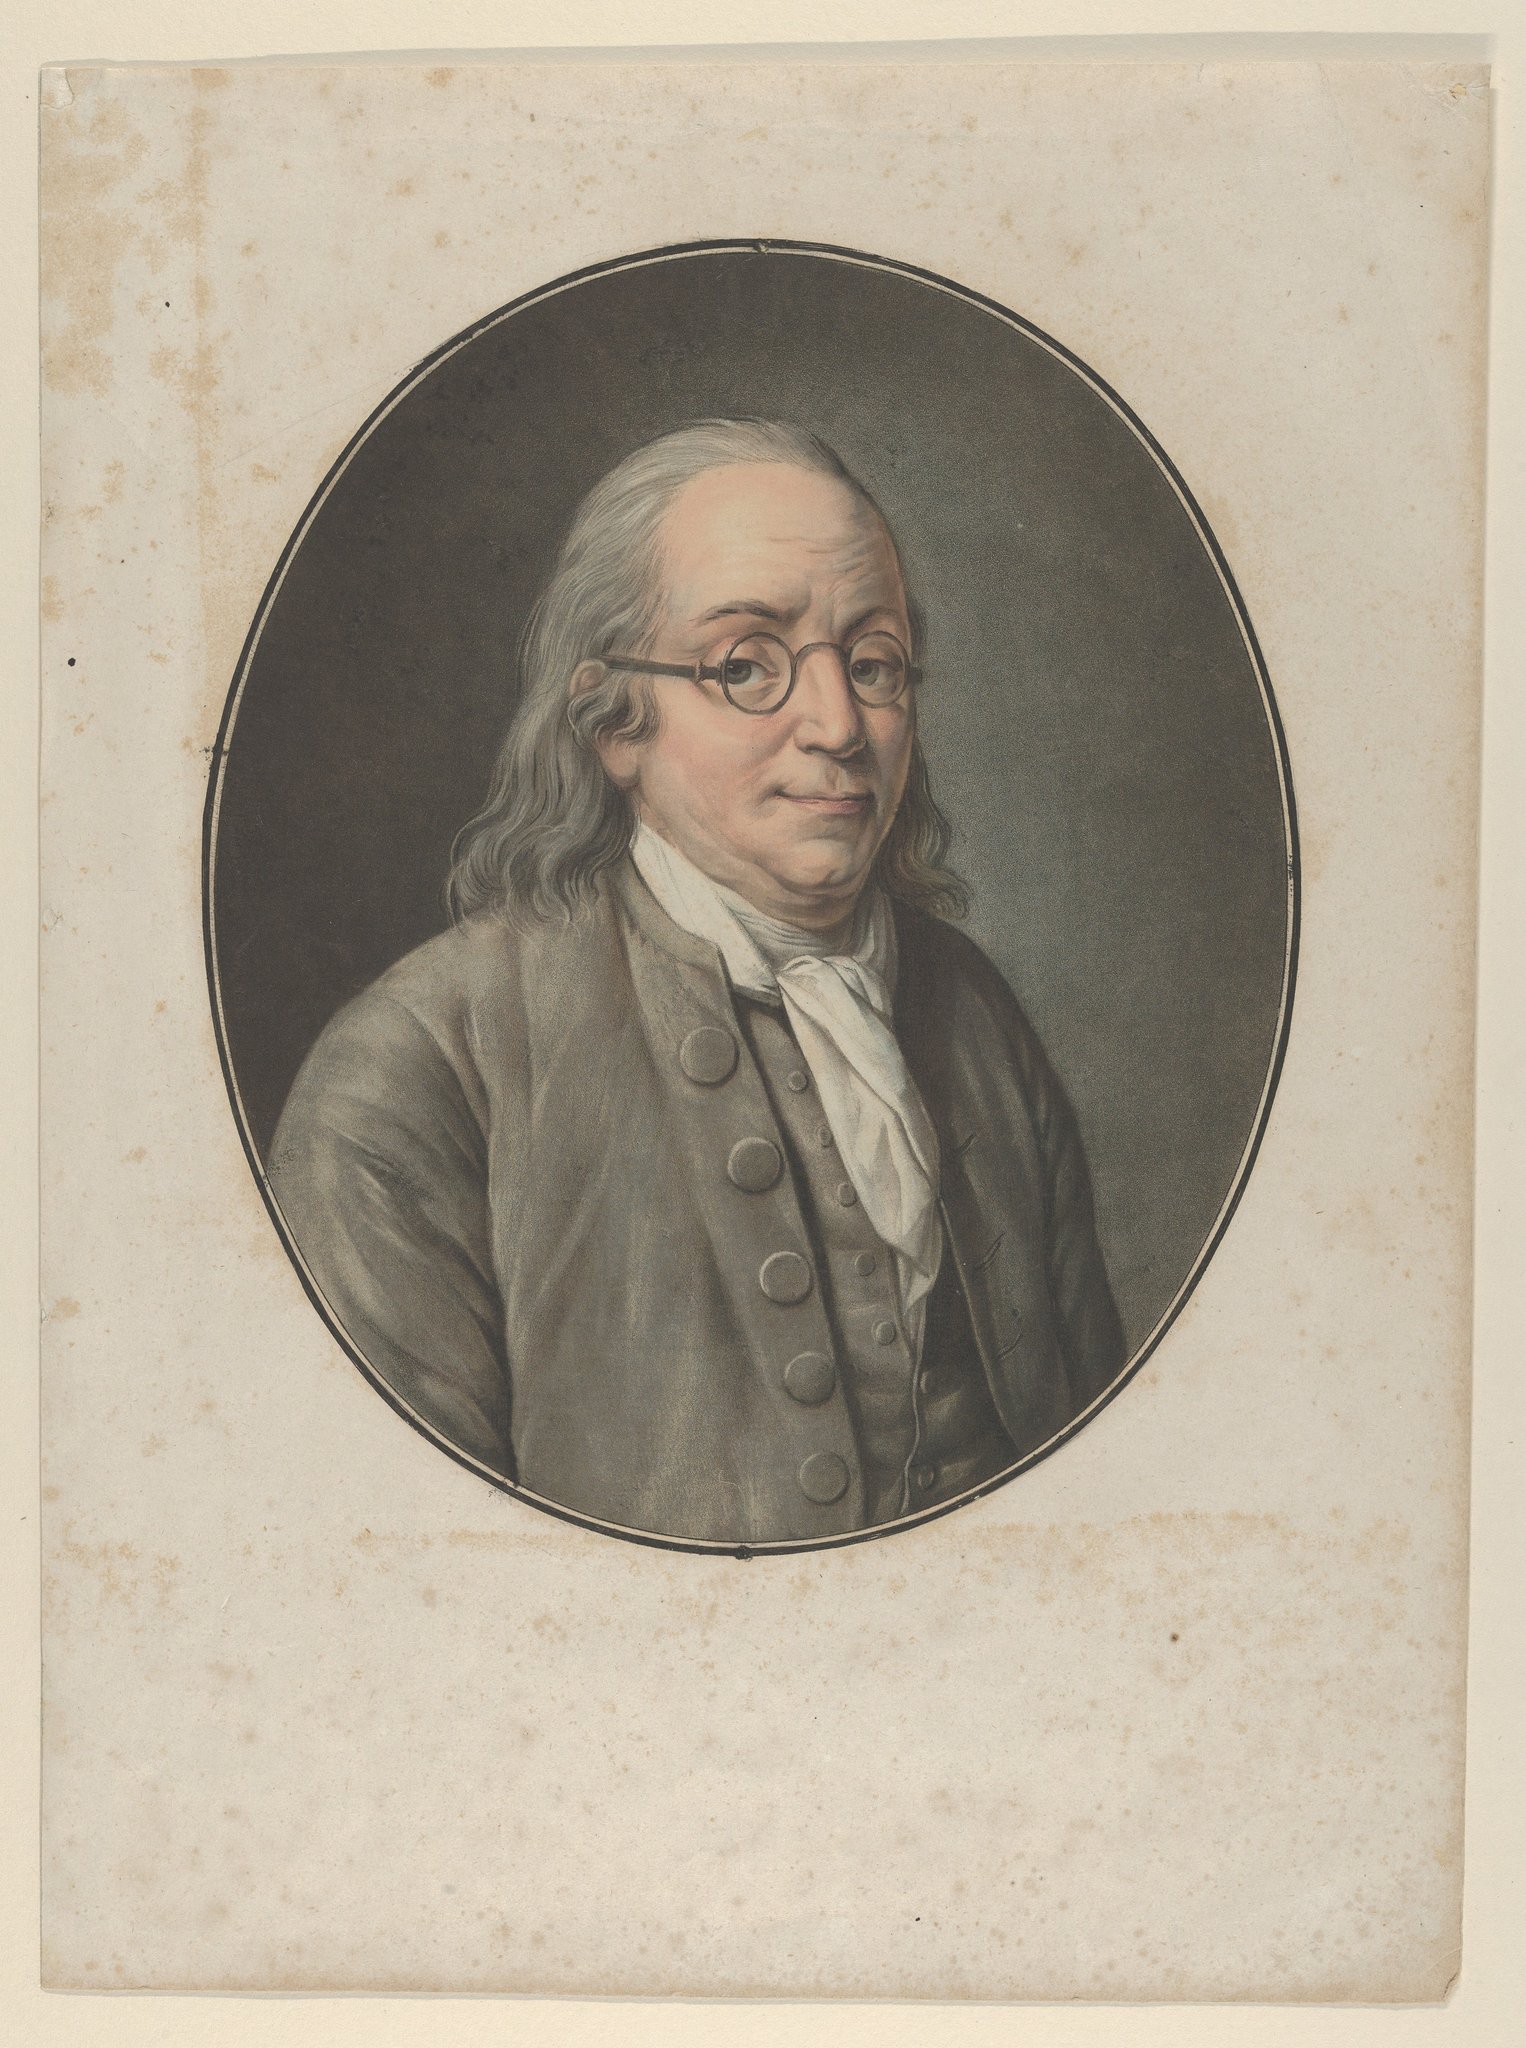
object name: print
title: Portrait of Franklin, after Vanloo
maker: pierre michel alix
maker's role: artist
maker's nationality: french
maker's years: 1762-1817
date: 1795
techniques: aquatint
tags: benjamin franklin,portraits